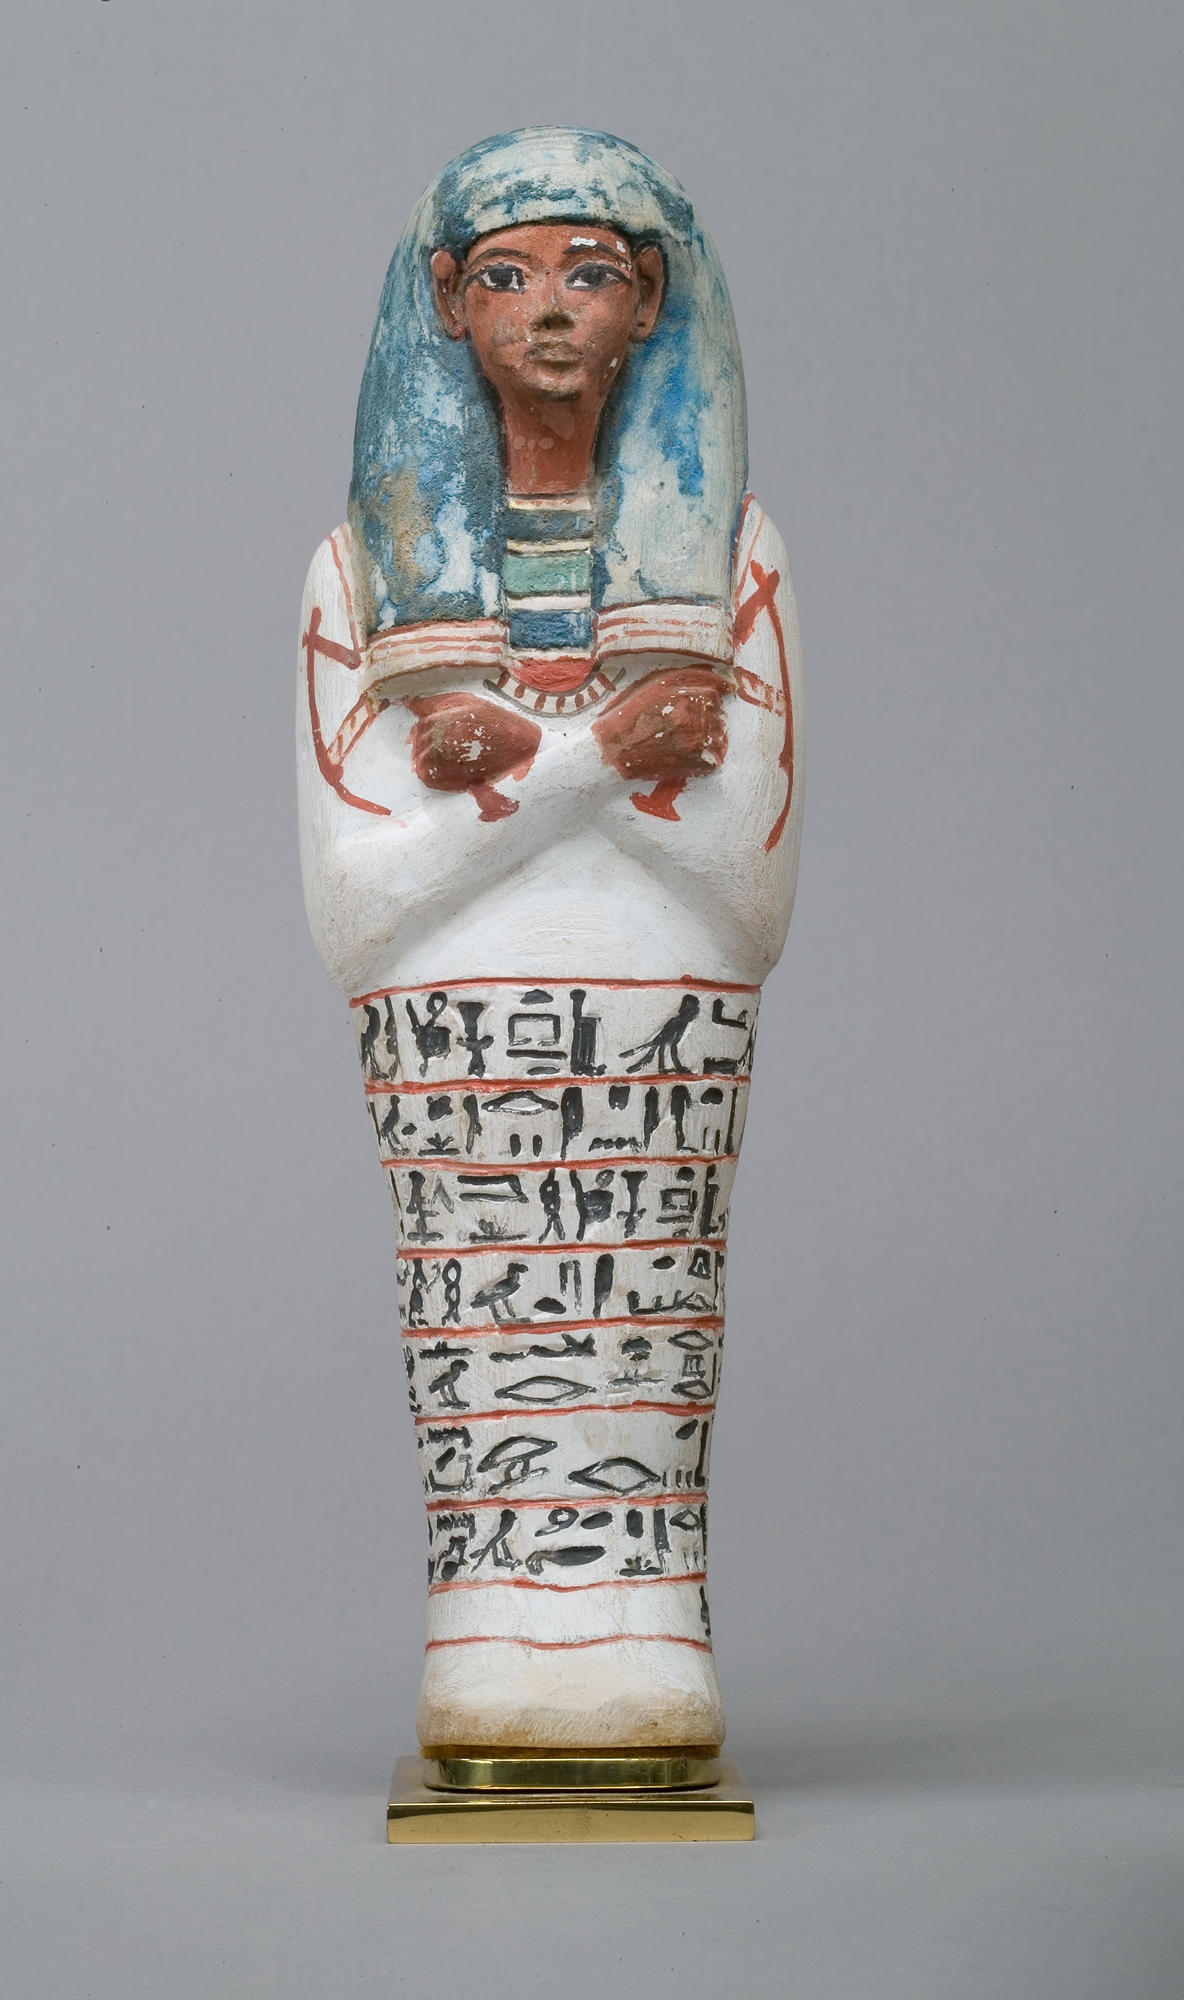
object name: shabti, sennedjem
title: Shabti of Sennedjem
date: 1279-1213 BCE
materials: limestone, paint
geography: egypt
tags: hieroglyphs